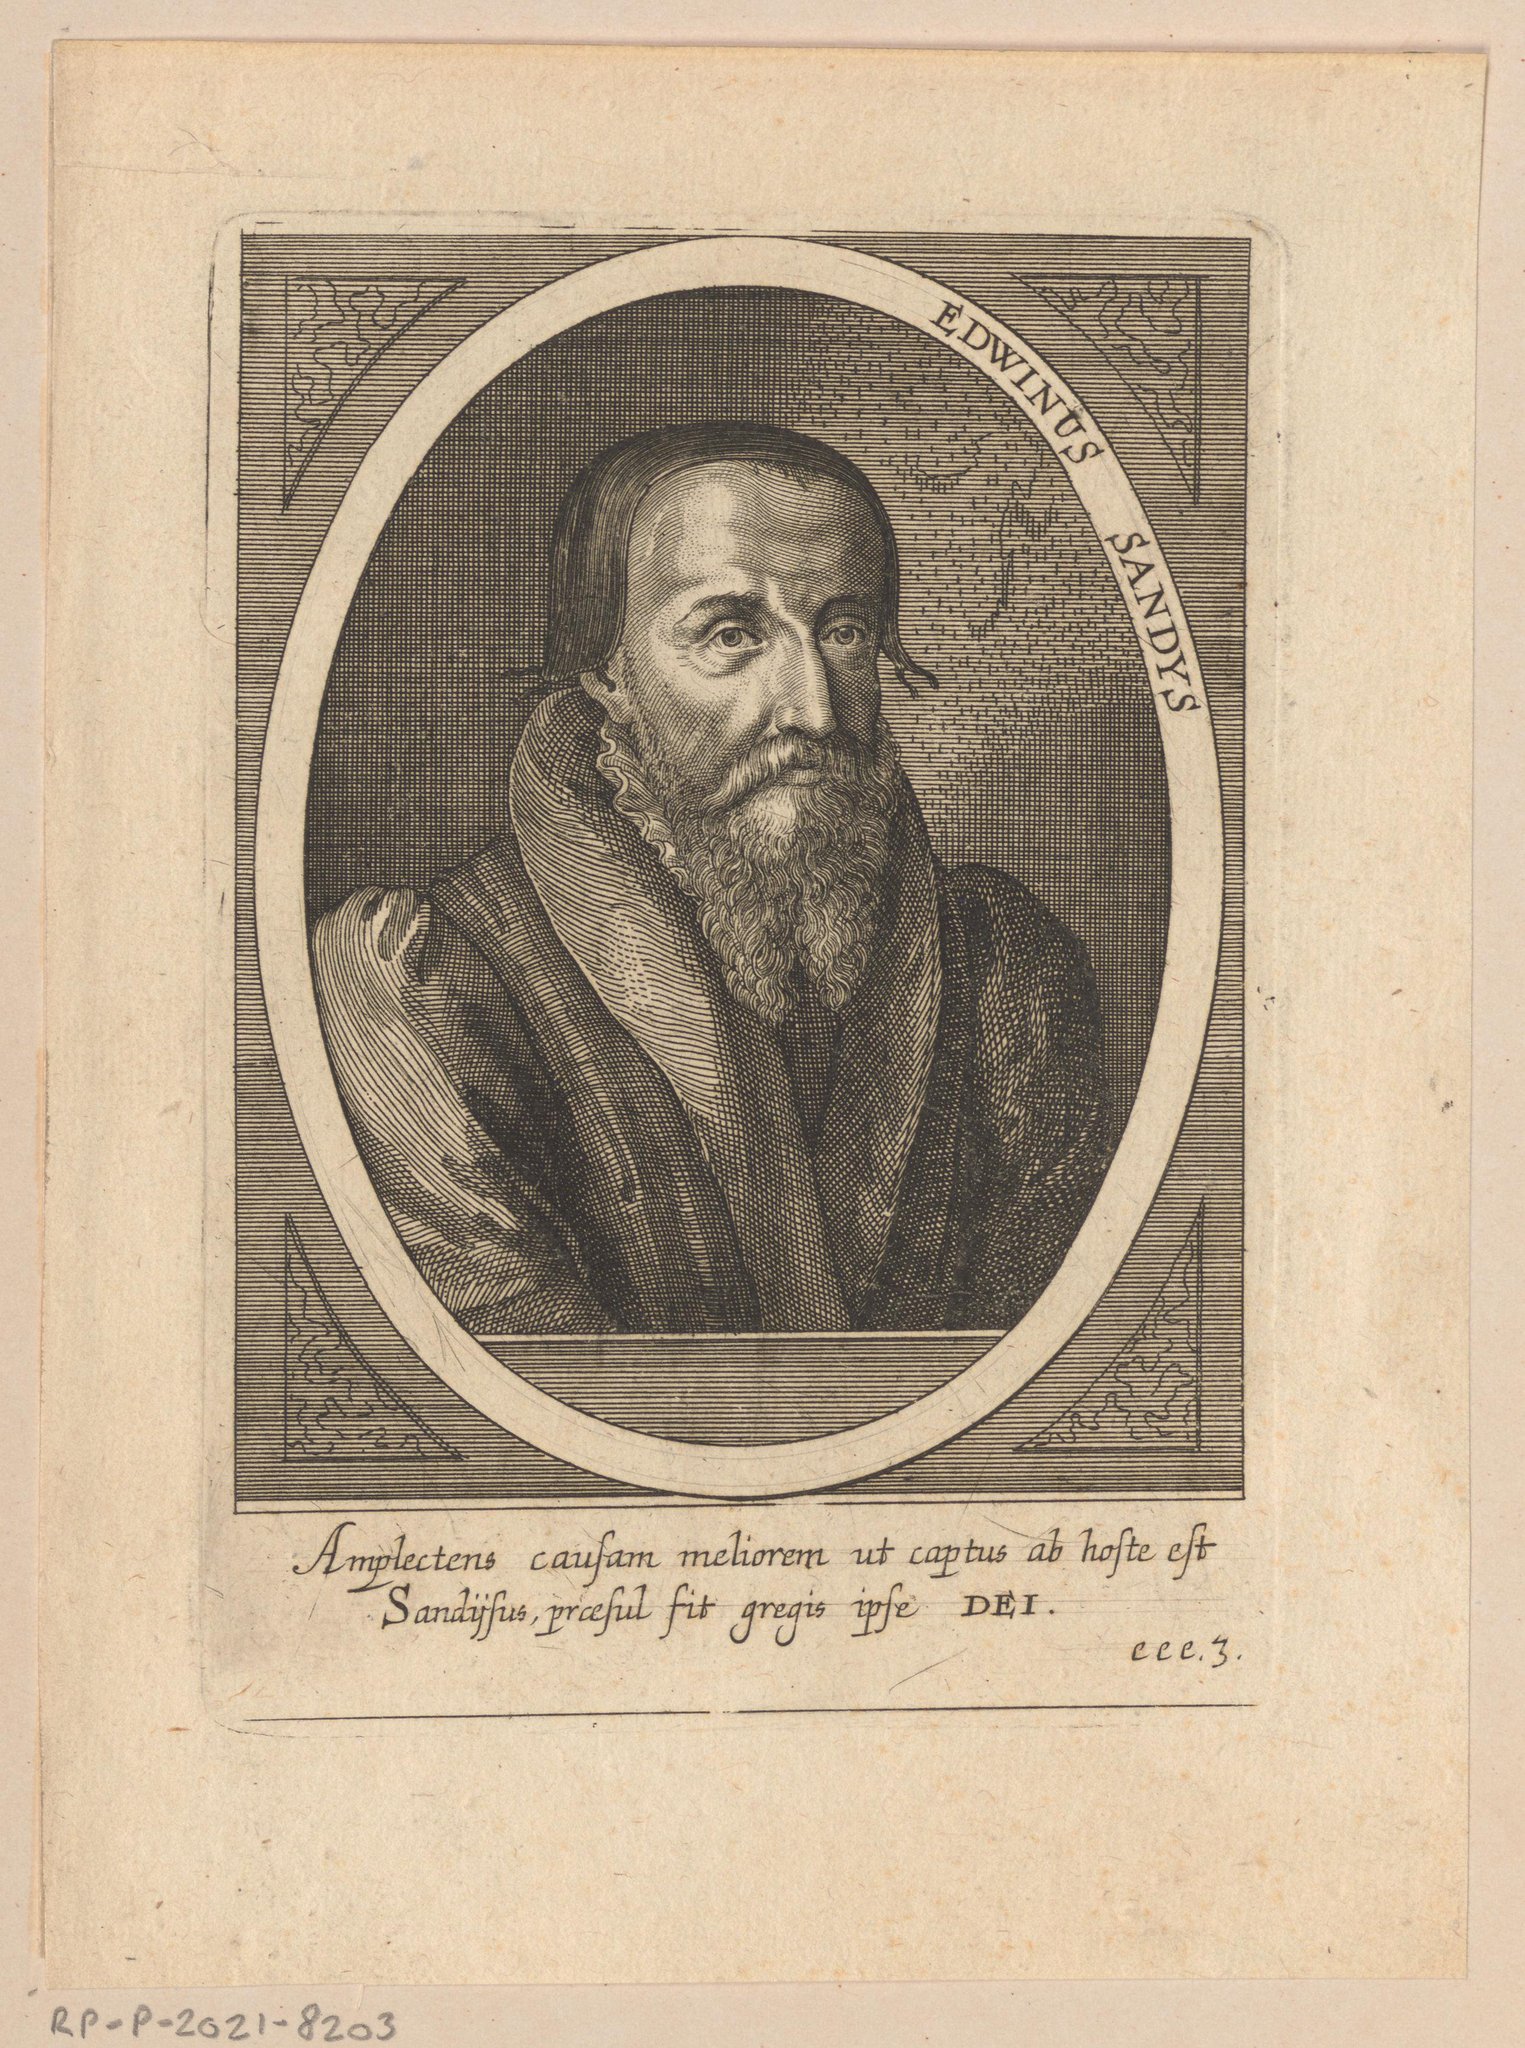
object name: print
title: Portret van Edwin Sandys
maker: Anonymous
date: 1652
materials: paper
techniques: engraving, etching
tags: archbishop, bishop, etc. (roman catholic), historical persons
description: Prent waarschijnlijk uit: Bibliotheca chalcographica (...). Frankfurt am Main: Johannes Ammon, 1652, dl 8.